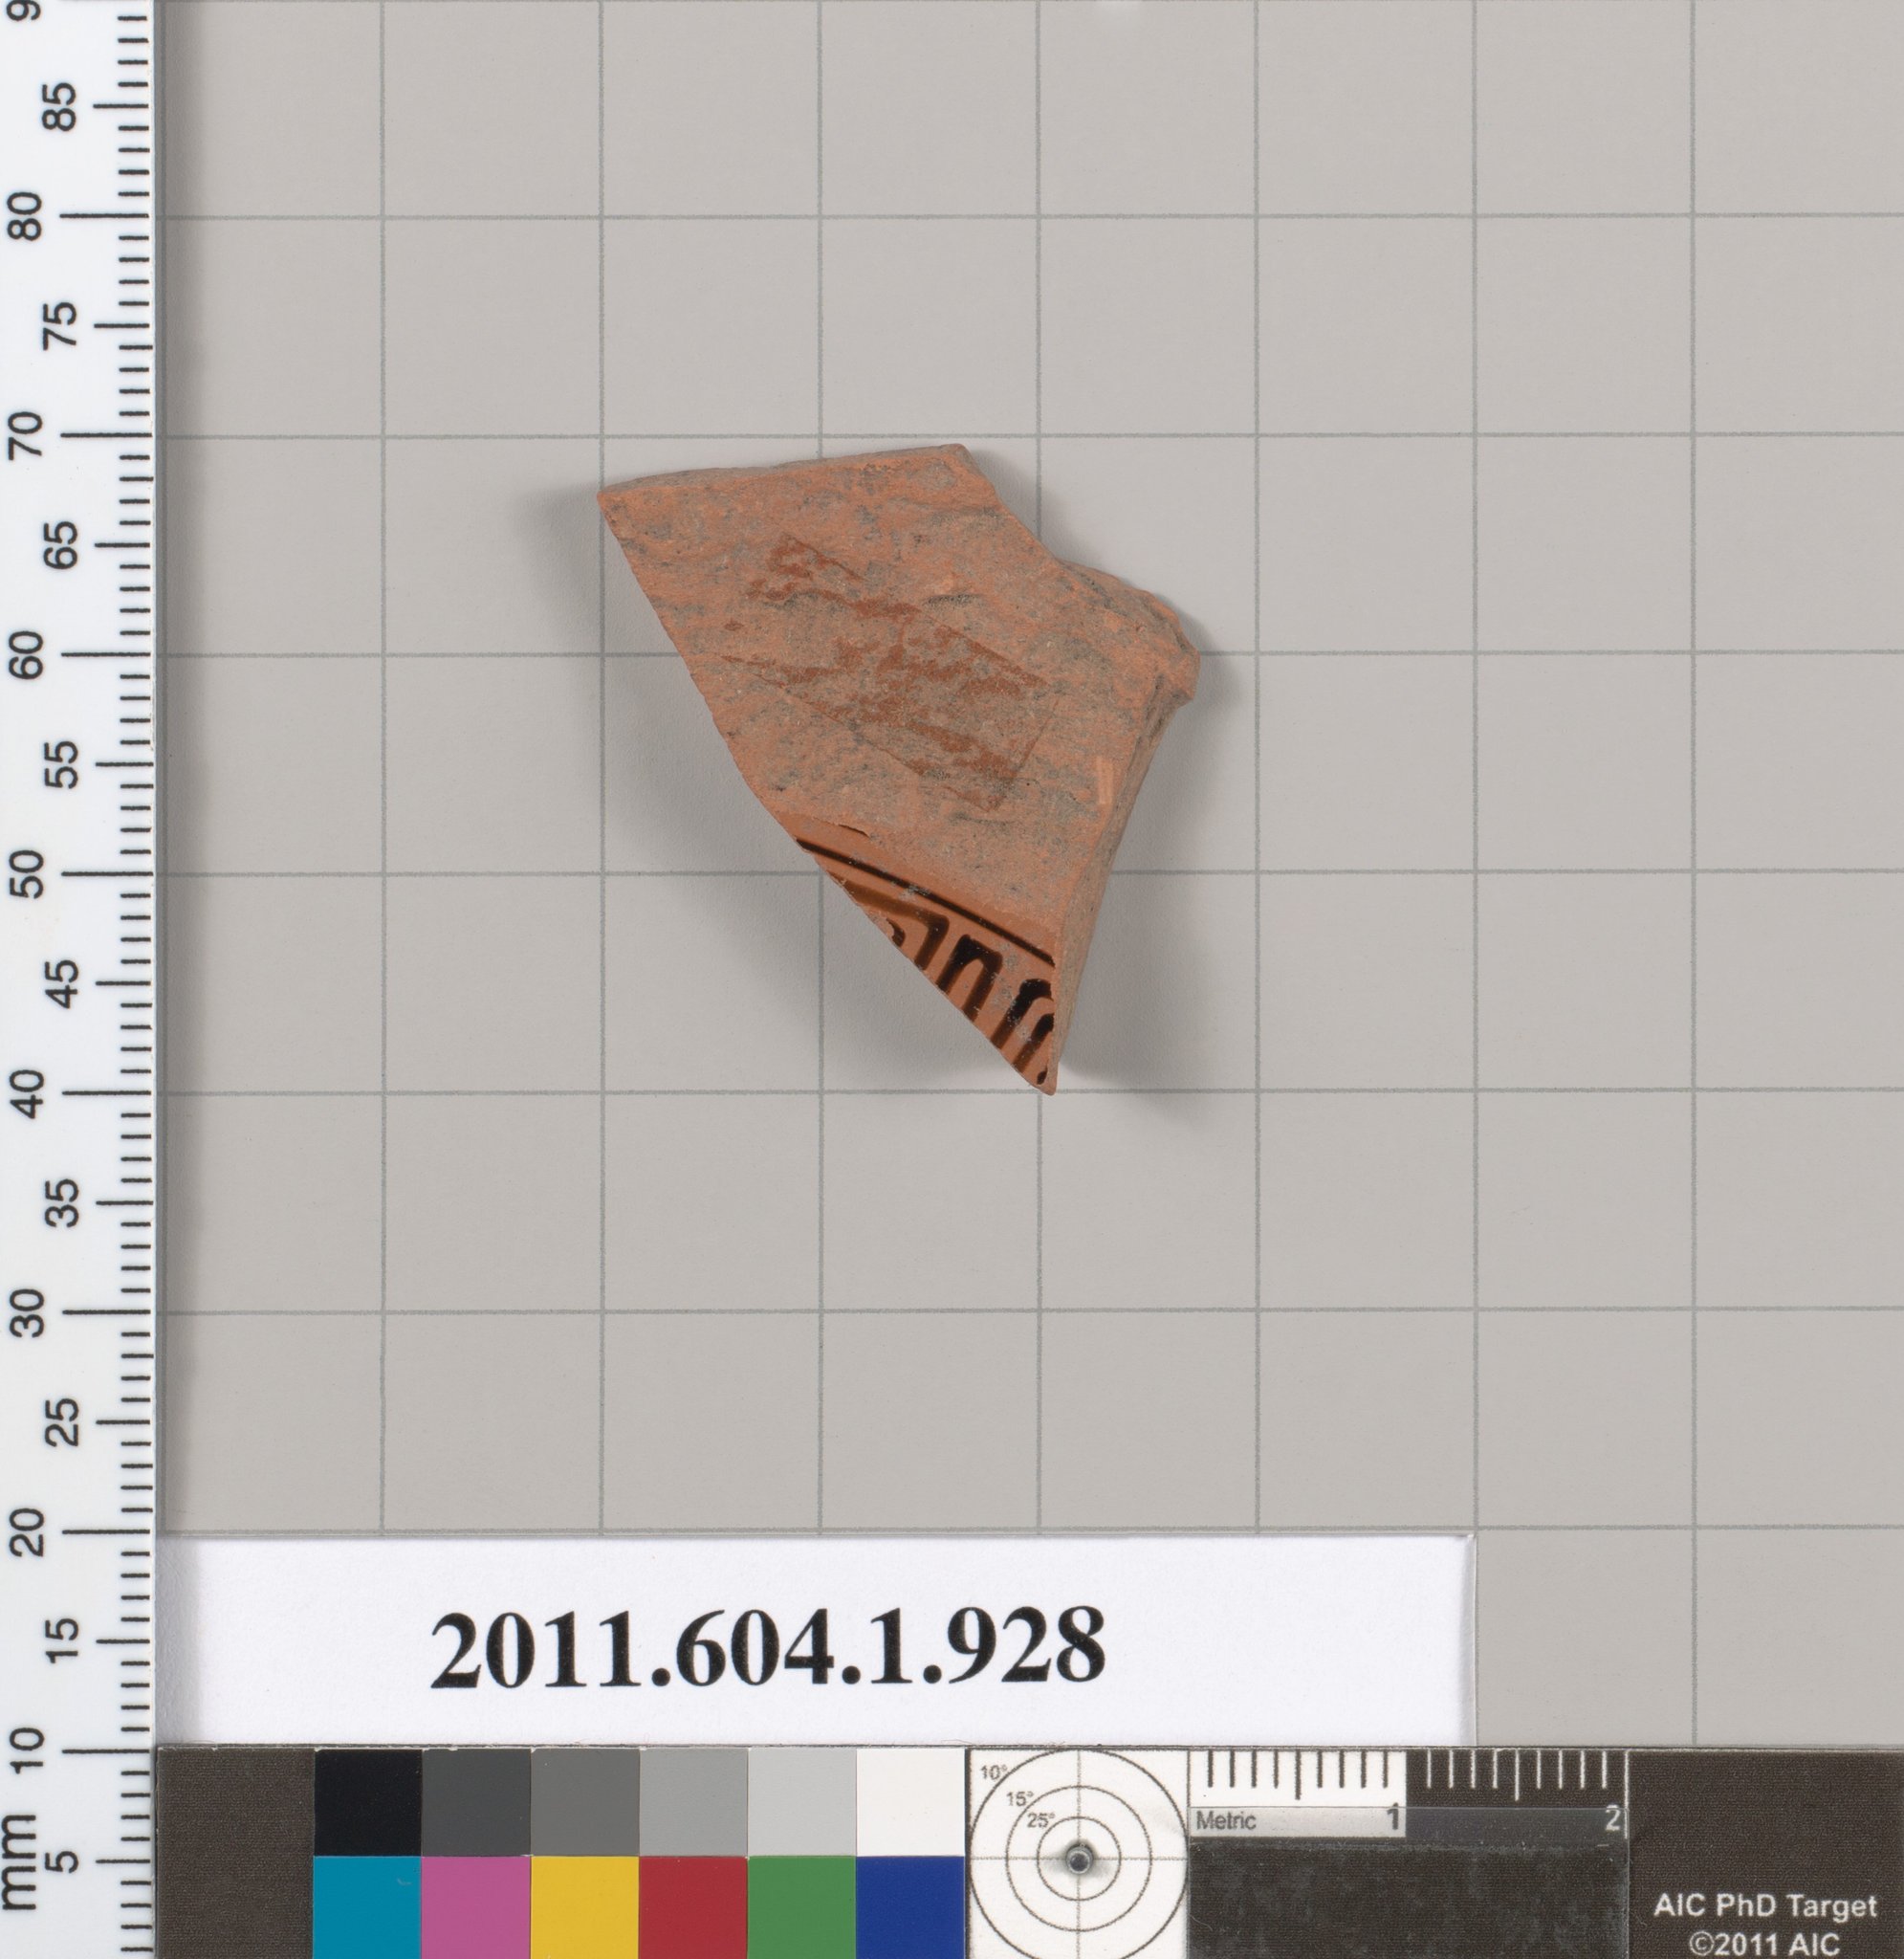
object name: kylix fragment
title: Terracotta fragment of a kylix (drinking cup)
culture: greek, attic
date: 490-480 BCE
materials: terracotta